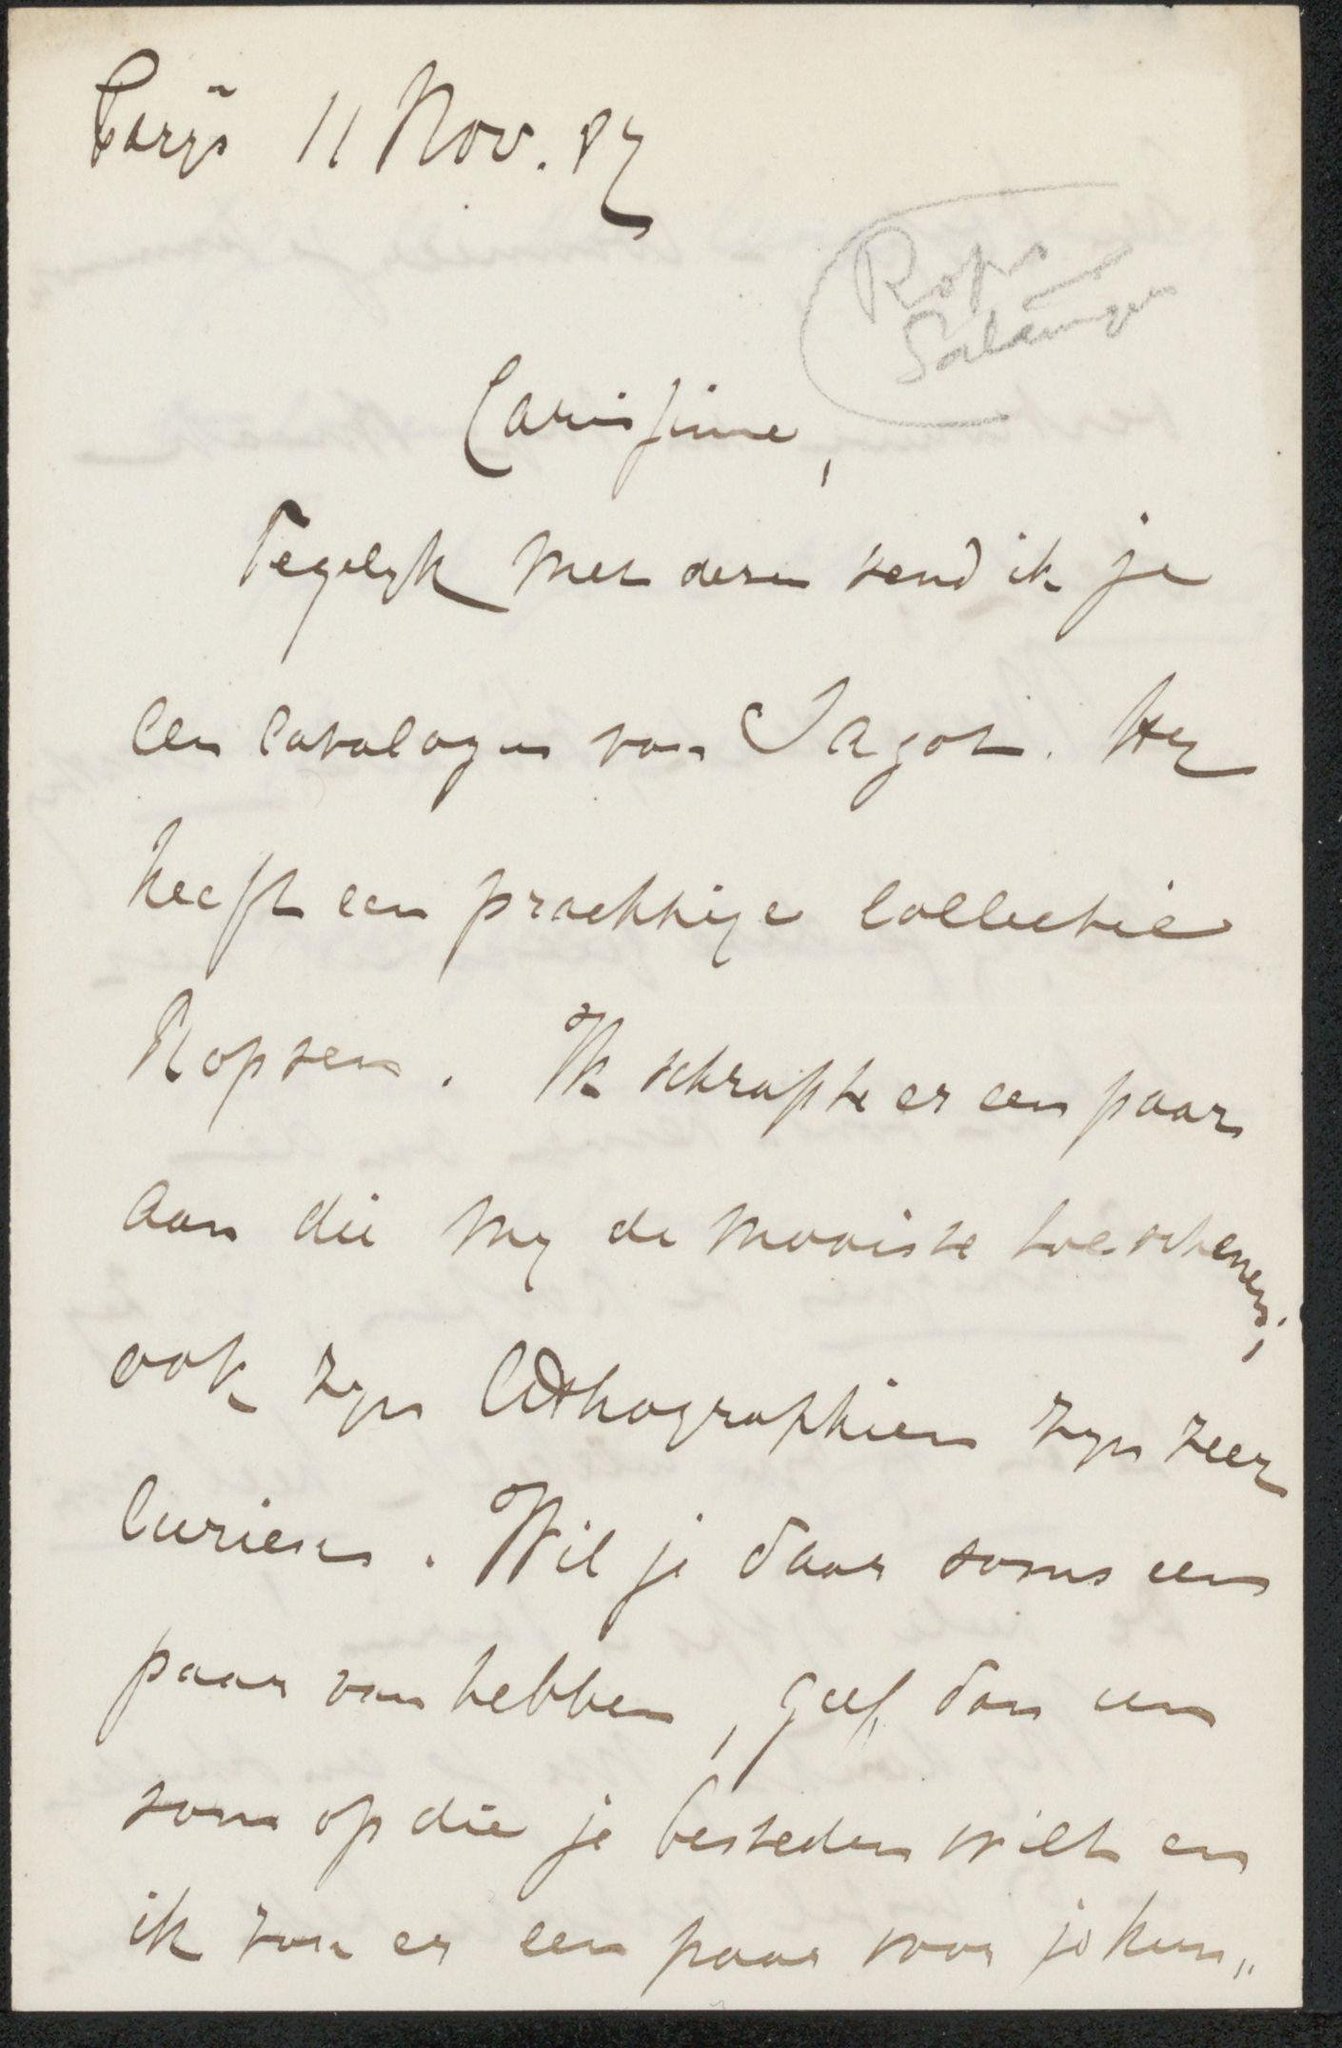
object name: letter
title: Brief aan Philip Zilcken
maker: adriaan pit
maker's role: print maker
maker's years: 1860-1944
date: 1887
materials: ink, paper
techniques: pen, writing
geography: paris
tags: publisher, edmond sagot, draughtsman, félicien rops, painter, philip zilcken, the graphic arts, painting (including book-illumination, miniature-painting), printed matter, brussels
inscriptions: watermark, collector's mark: ‘RPK’